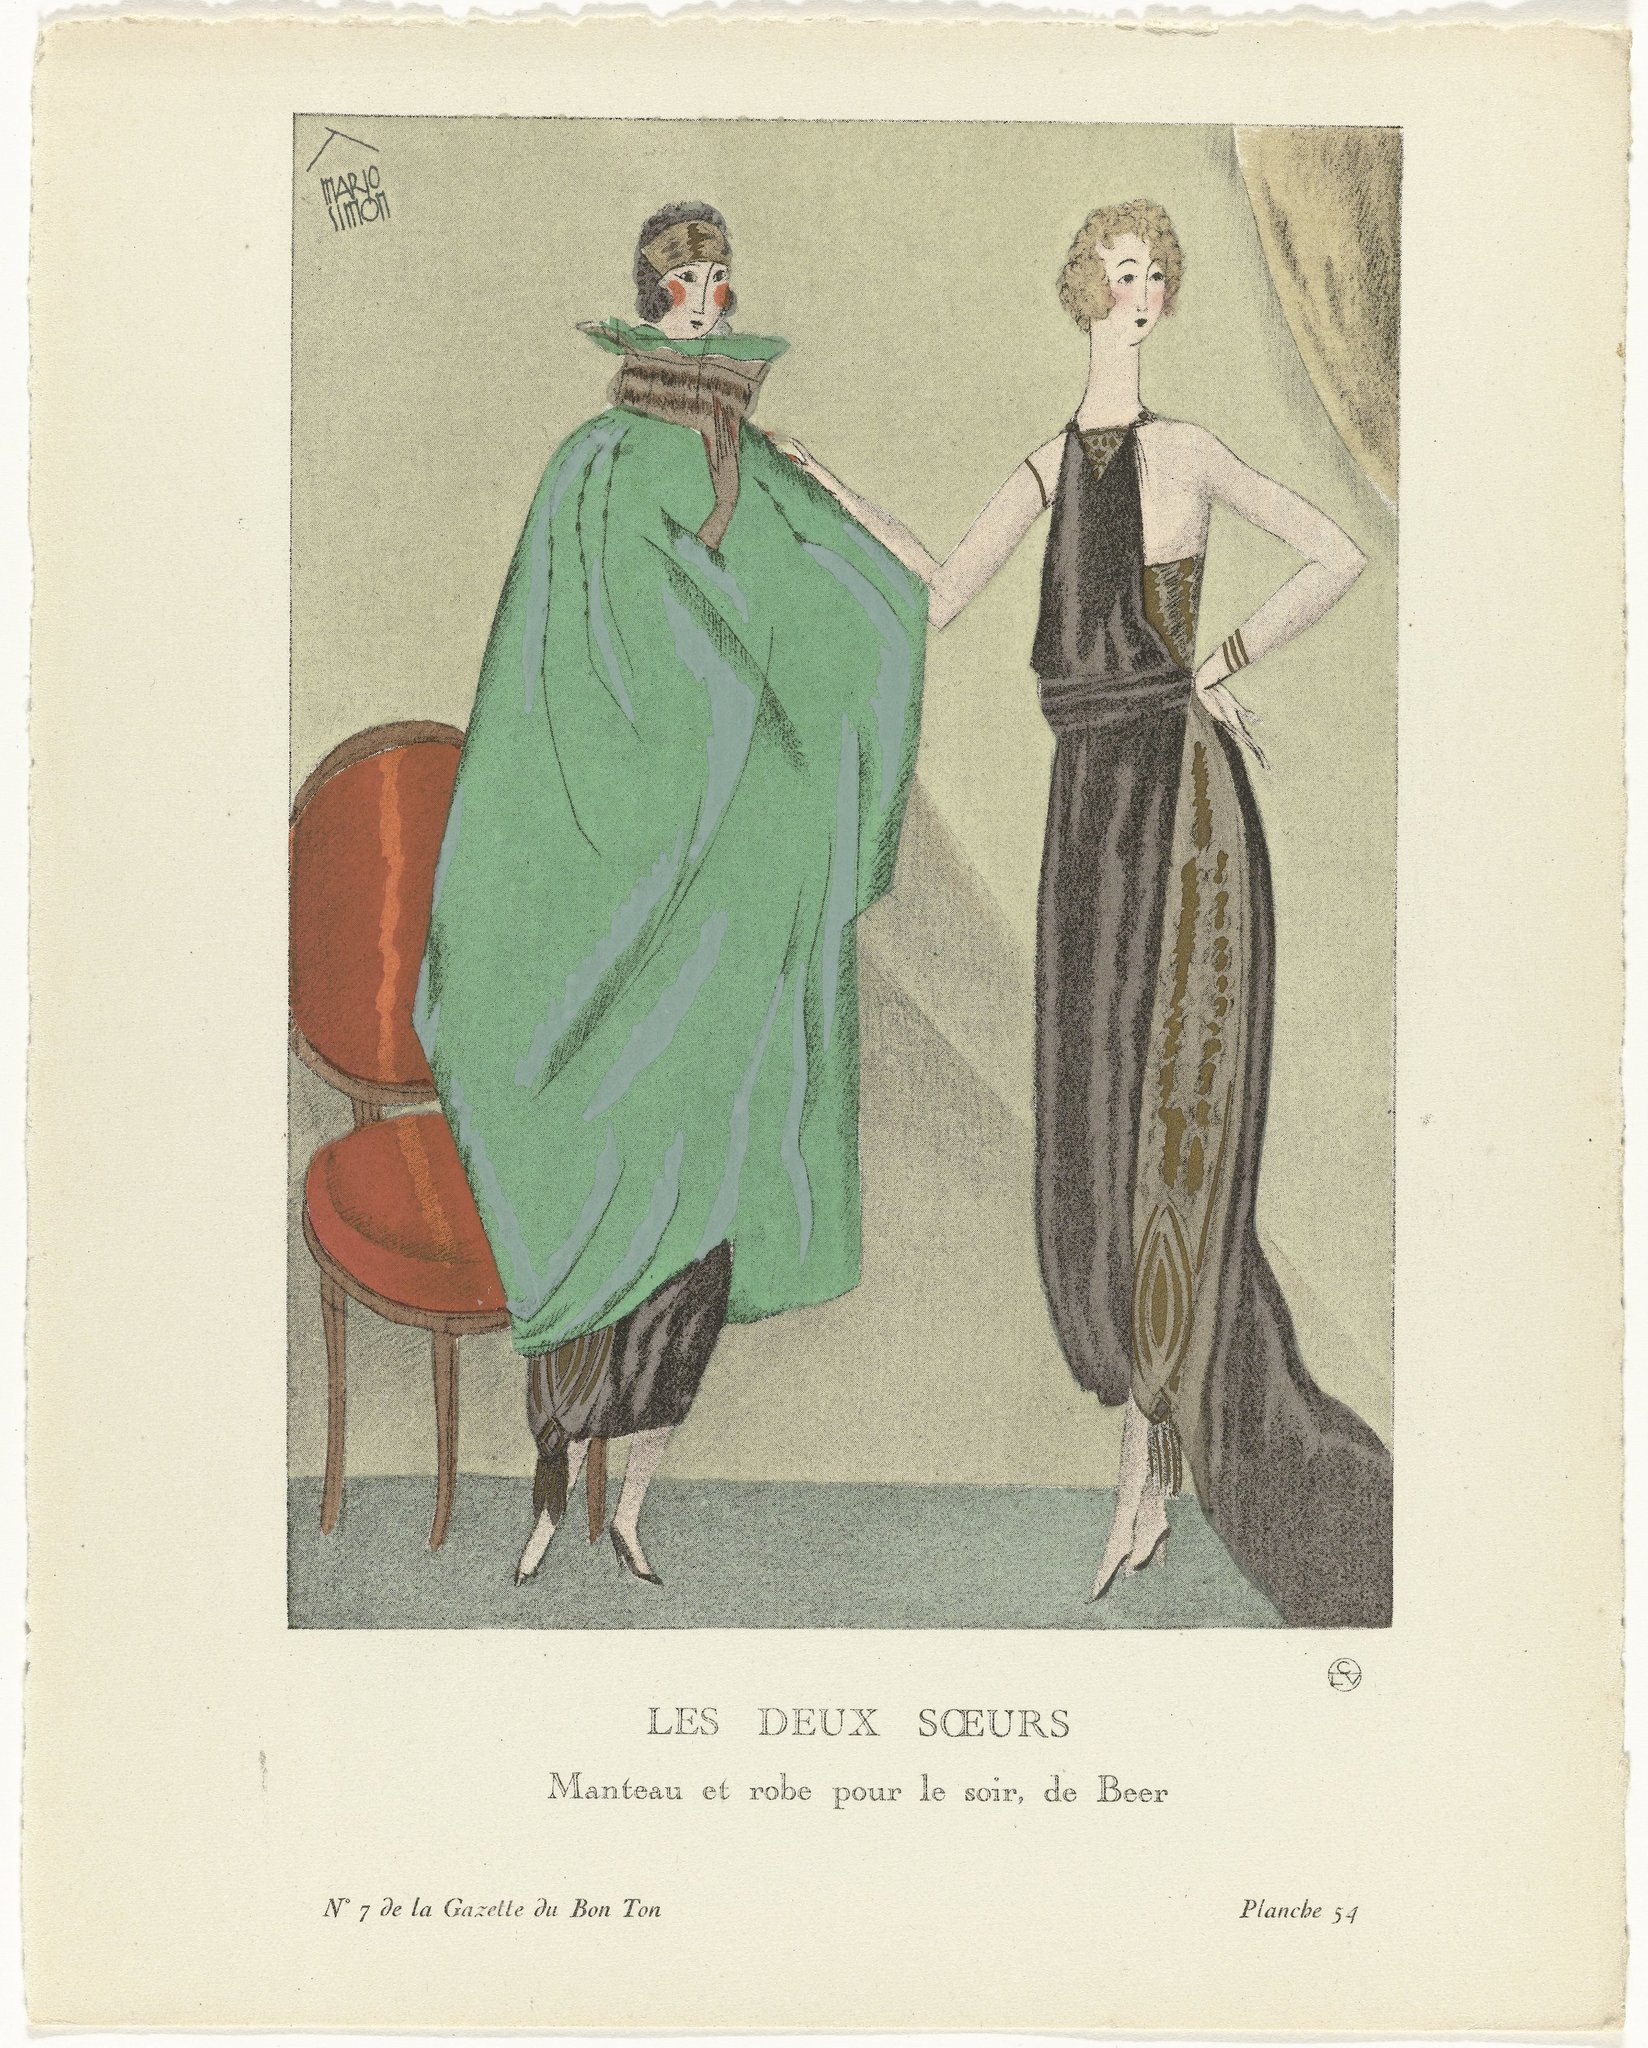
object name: fashion print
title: Gazette du Bon Ton, 1920 - No. 7, Pl. 54: Les deux soeurs / Manteau et robe pour le soir, de Beer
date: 1920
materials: paper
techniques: hand coloring, letterpress printing, photochemical processes, pochoir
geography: new york city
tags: dress, gown: evening dress (+ women's clothes), coat (evening coat) (+ women's clothes), fashion plates, stool, bracelet, wristlet (+ women's clothes)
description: Avondmantel en een zwarte avondjapon van zijdefluweel, van Beer. Planche 54 uit Gazette du Bon Ton 1920, No. 7. Uitleg over de kleding op pagina "Explication des Planches".